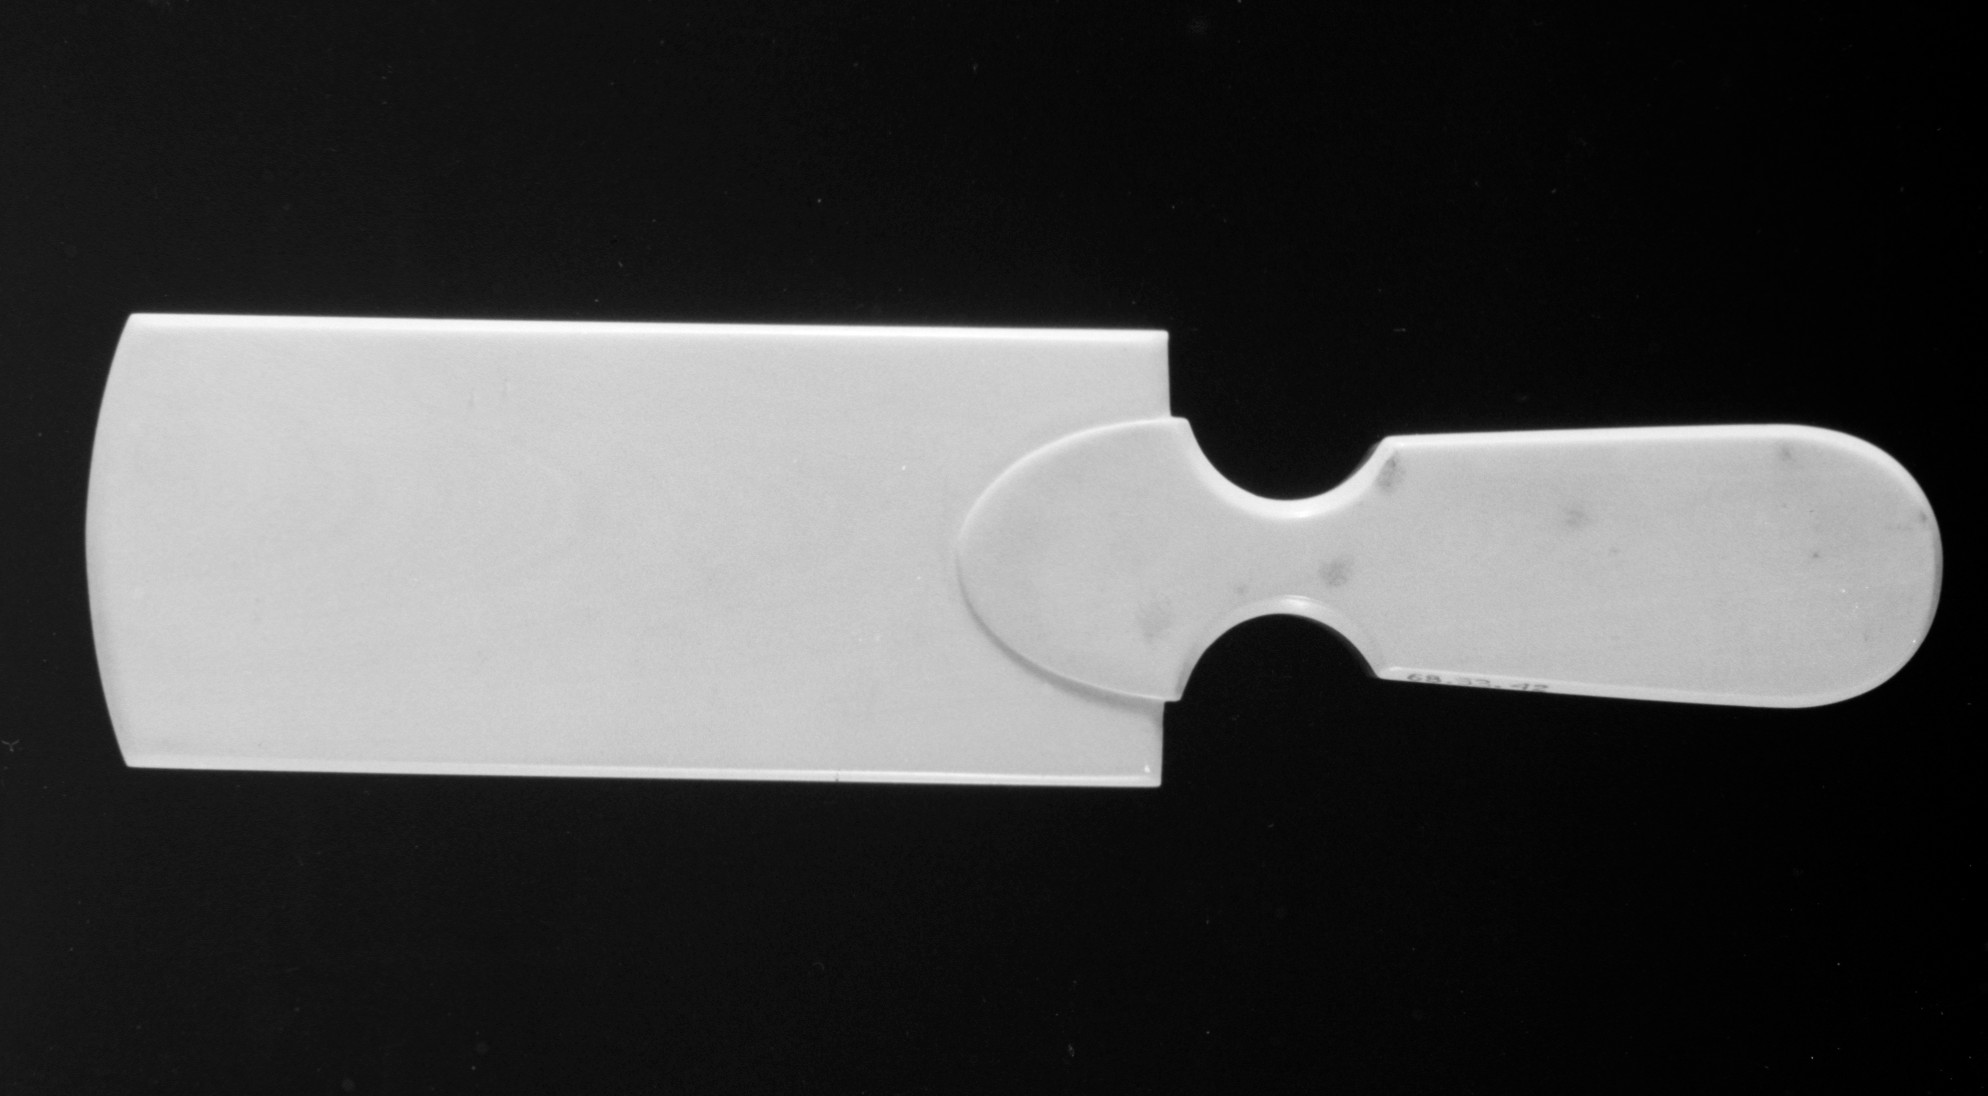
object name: hairbrush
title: Hairbrush (part of a set)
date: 1848-1849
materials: ivory